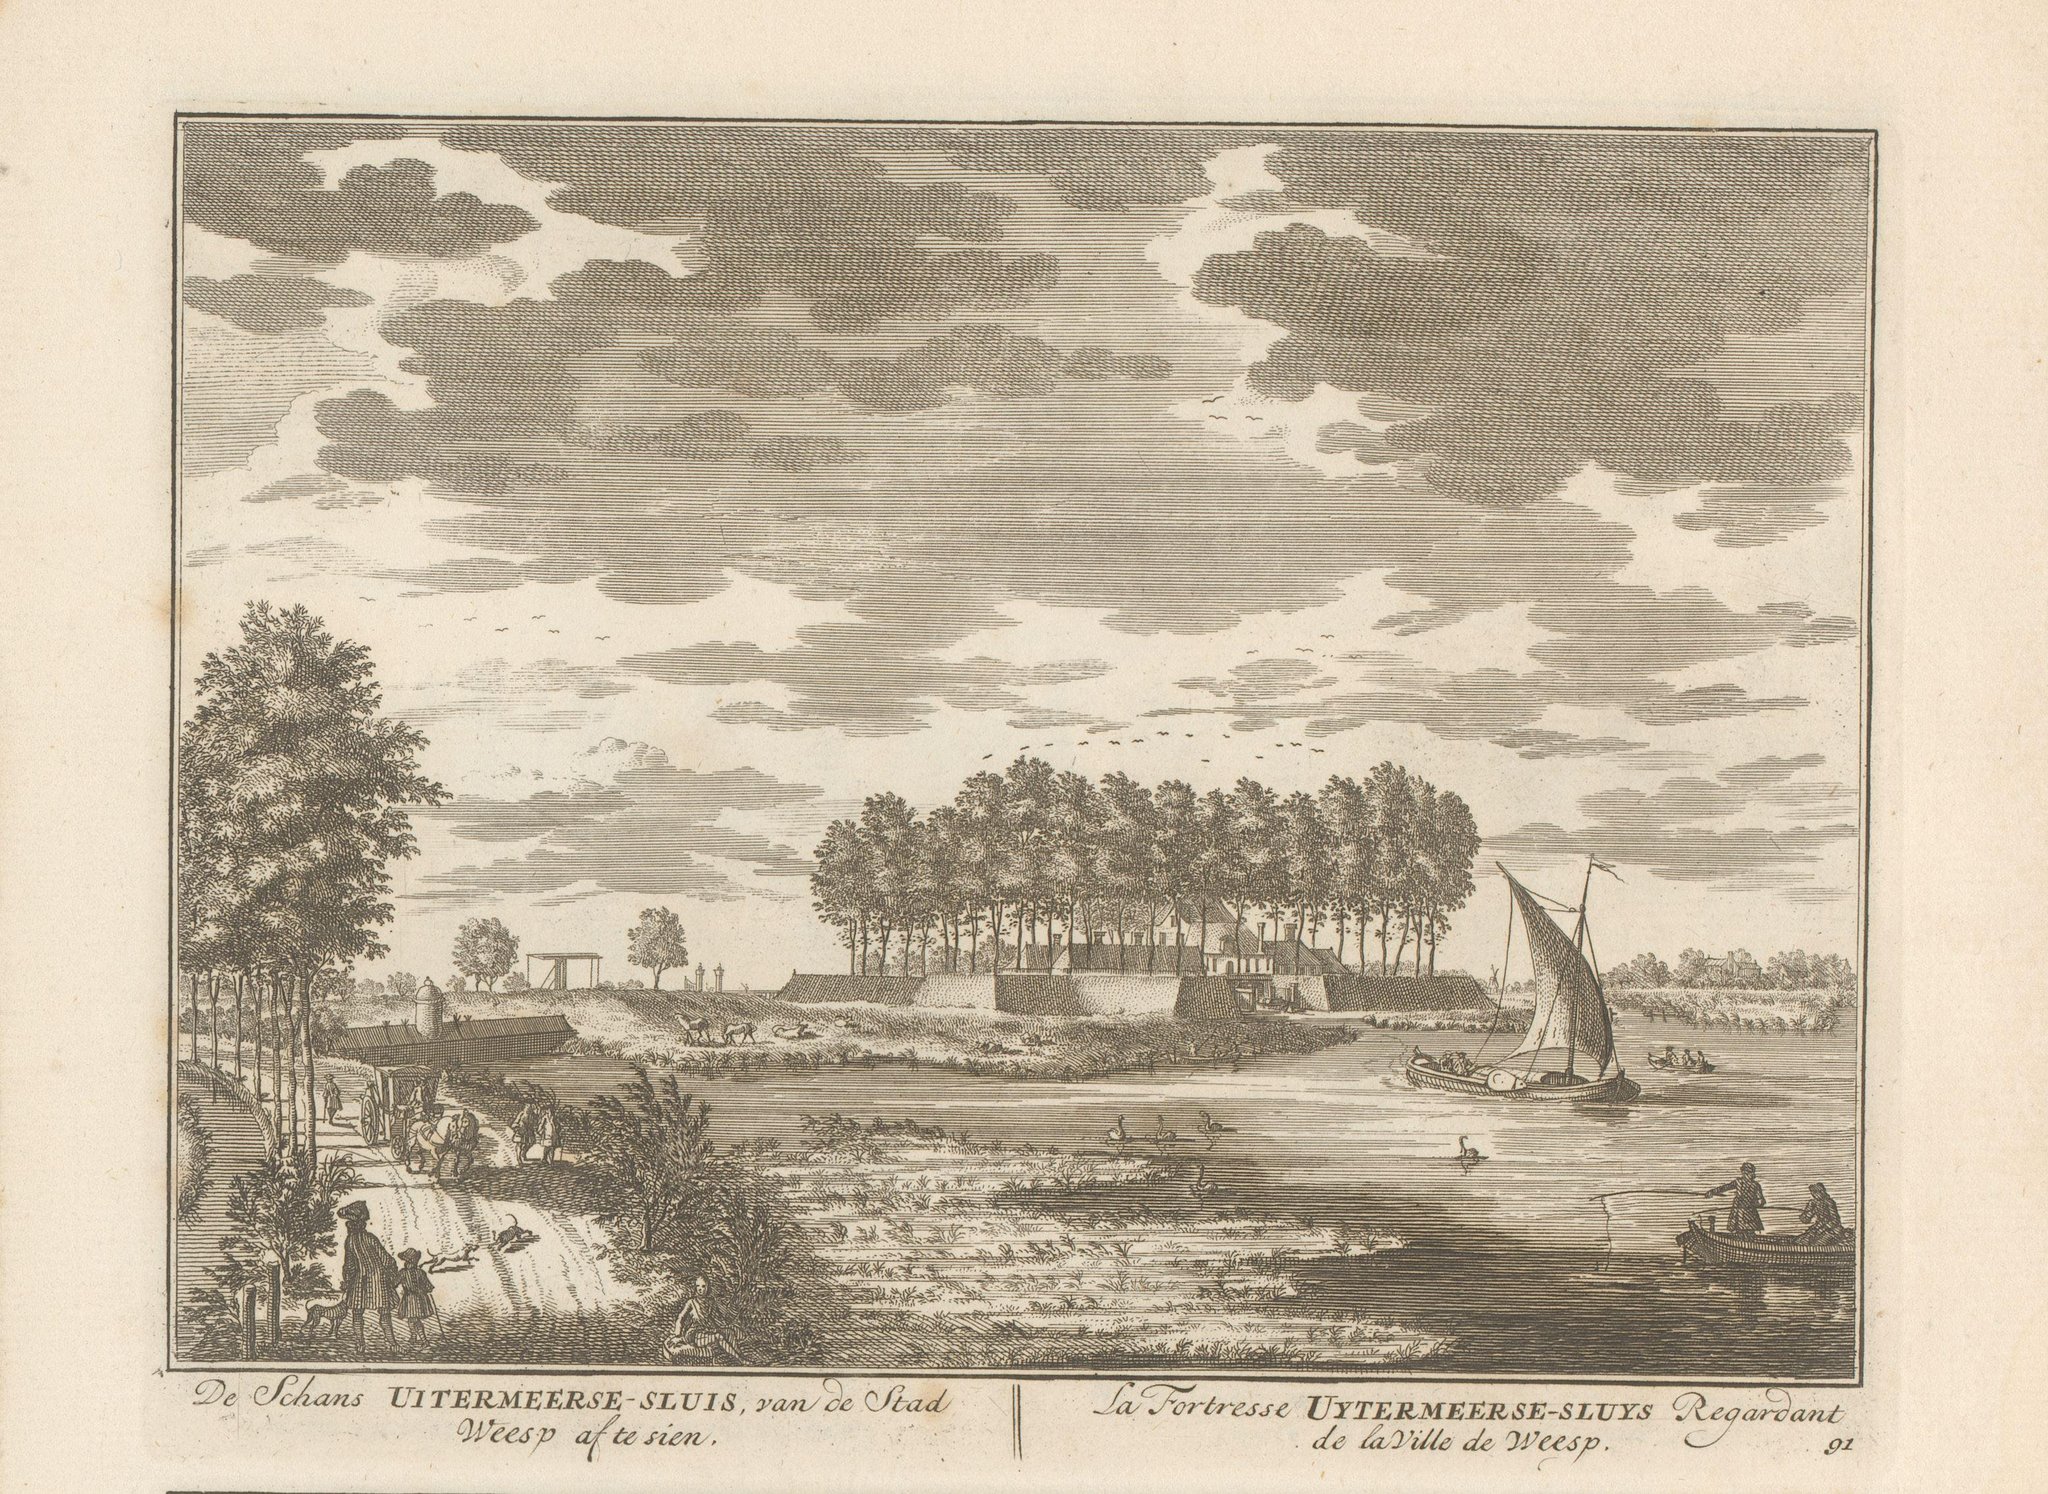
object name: book illustration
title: Gezicht op Uitmeerse Sluis bij Weesp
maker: daniël stopendaal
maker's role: print maker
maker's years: 1672-1726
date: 1790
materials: paper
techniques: engraving, etching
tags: sluice, weir, river (+ landscape with figures, staffage), vecht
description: Prent gebruikt in: Leth, Andries de. De zegepraalende Vecht, vertoonende verscheidene gesichten van lustplaatsen, heeren huysen en dorpen, beginnende van Uitrecht en met Muyden besluytende (...). Amsterdam: Weduwe Nicolaus Visscher, 1719. Prent ook gebruikt in: Brouërius van Nidek, Matthaeus. De Vechtstroom, van Utrecht tot Muiden (...). Amsterdam: H. Gartman, W. Vermandel en J.W. Smit, 1790.